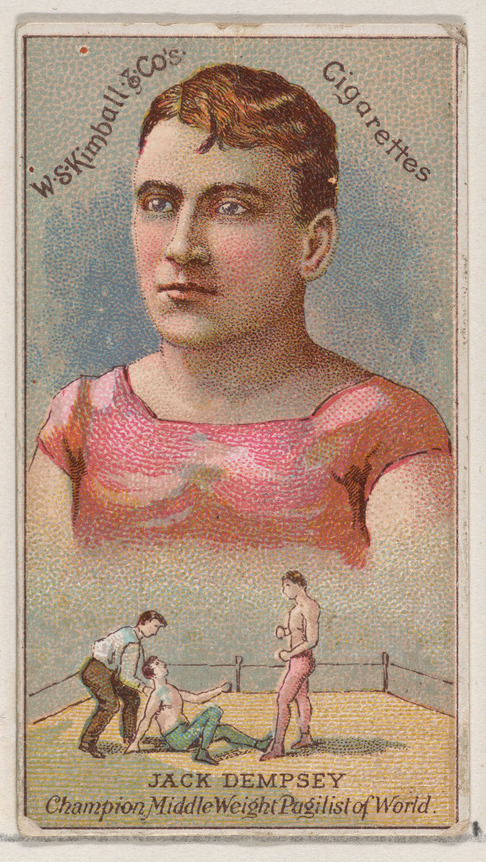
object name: print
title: Jack Dempsey, Champion Middle Weight Pugilist of the World, from the Champions of Games and Sports series (N184, Type 1) issued by W.S. Kimball & Co.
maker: w.s. kimball & co.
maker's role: publisher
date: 1887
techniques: color lithograph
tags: men,boxing,athletes